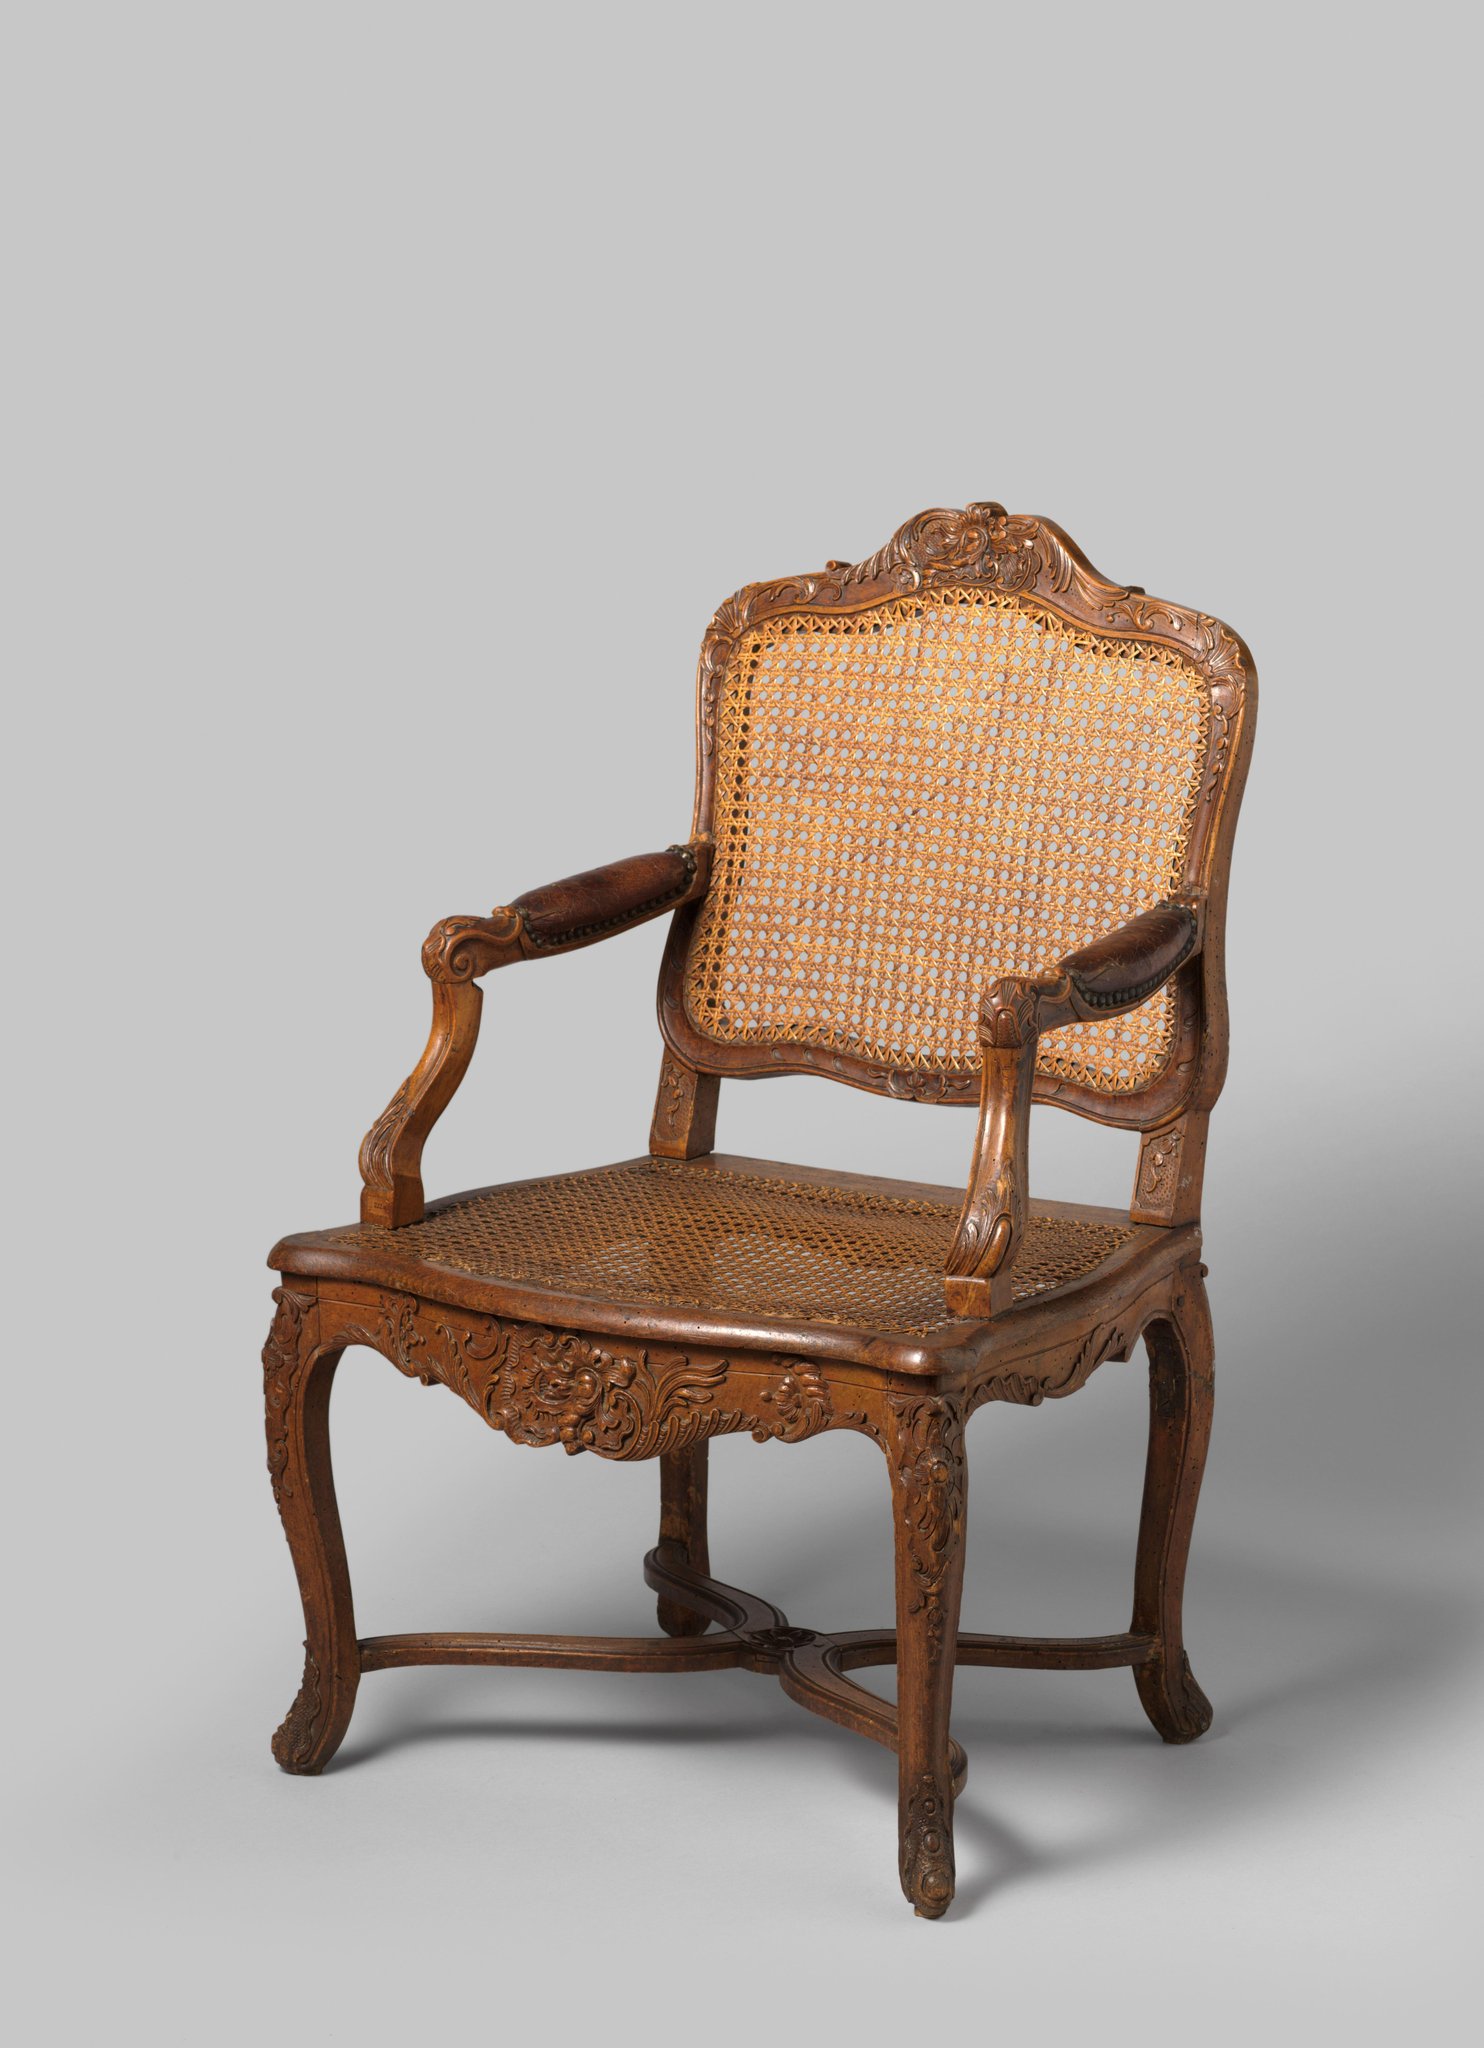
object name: armchair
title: Armstoel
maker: Anonymous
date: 1725-1750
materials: wood, leather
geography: france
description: Armstoel van bruin gelakt beukenhout, met riet bespannen. De S-vormige poten, door een geslingerd X-vormig kruis verbonden, gaan in de zitregels over. Diverse onderdelen dragen gestoken versieringen. Het trapeziumvormige zitraam is aan de voorkant geschulpt en aan de zijkanten gewelfd. De armleggerstutten zijn achterwaarts geplaatst en gaan S-vormig in de buitenwaarts wijkende armleggers, eindigend in een voluut, over. Het gestutte rugraam, aan boven- en onderkant geschulpt, heeft gestrekt S-vormige stijlen.